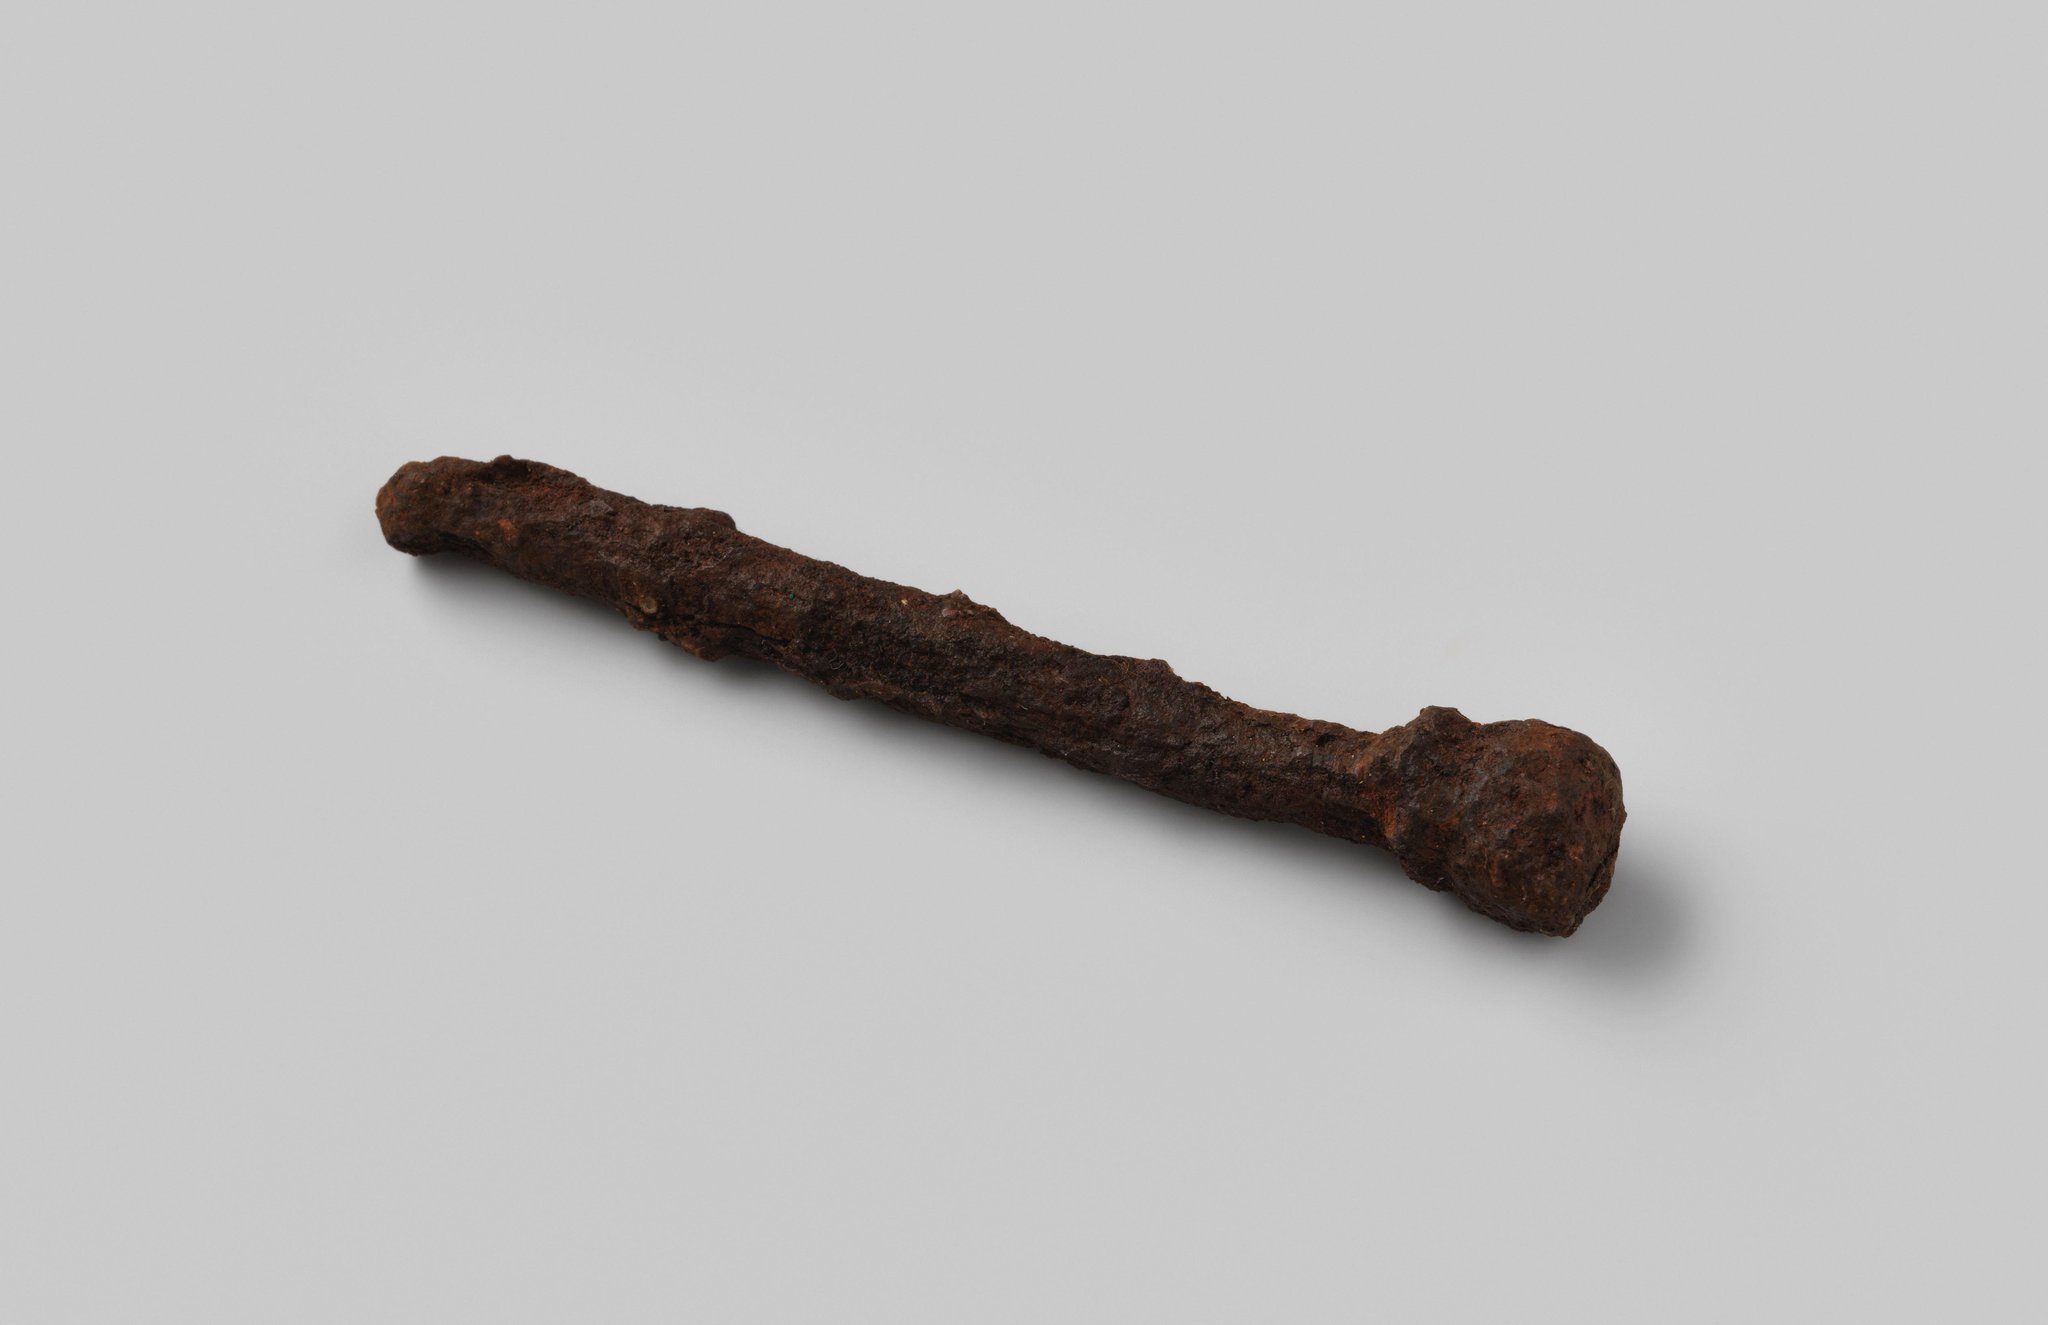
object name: helve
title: Fragment ijzeren steel uit het wrak van de Oost-Indiëvaarder Hollandia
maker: Anonymous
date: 1700-1743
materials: iron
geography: netherlands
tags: verenigde oostindische compagnie, hollandia (schip), annet